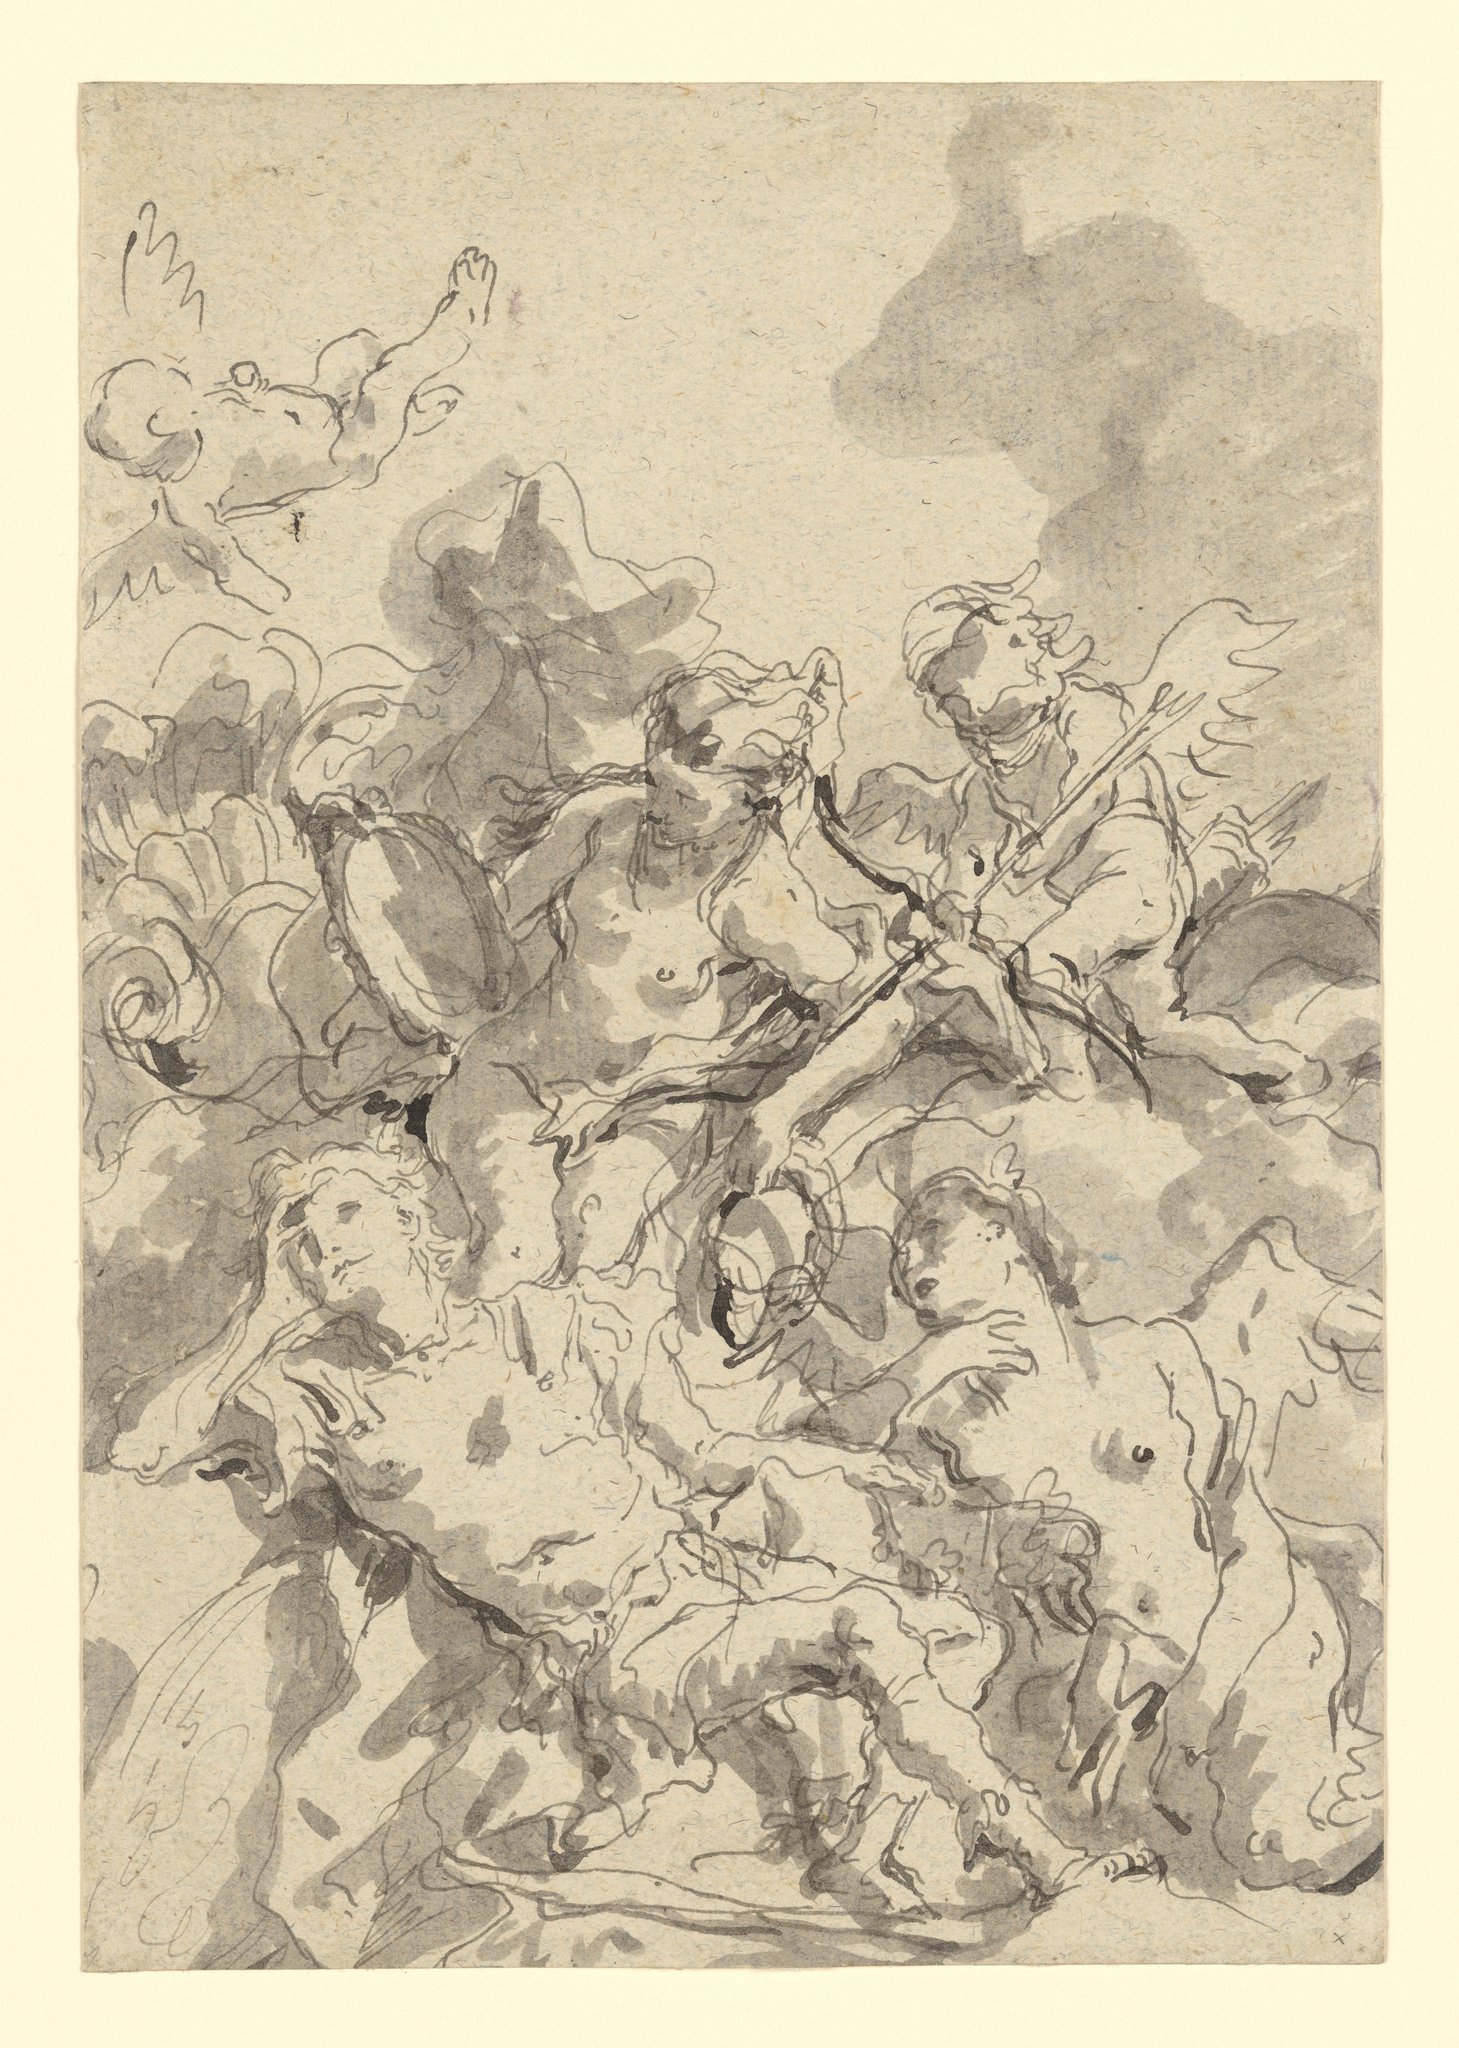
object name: drawing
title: Rinaldo Enchanted by Armida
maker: giovanni domenico tiepolo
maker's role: artist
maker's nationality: italian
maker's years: 1727-1804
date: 1734-1800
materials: ink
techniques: pen, wash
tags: men,female nudes,putti